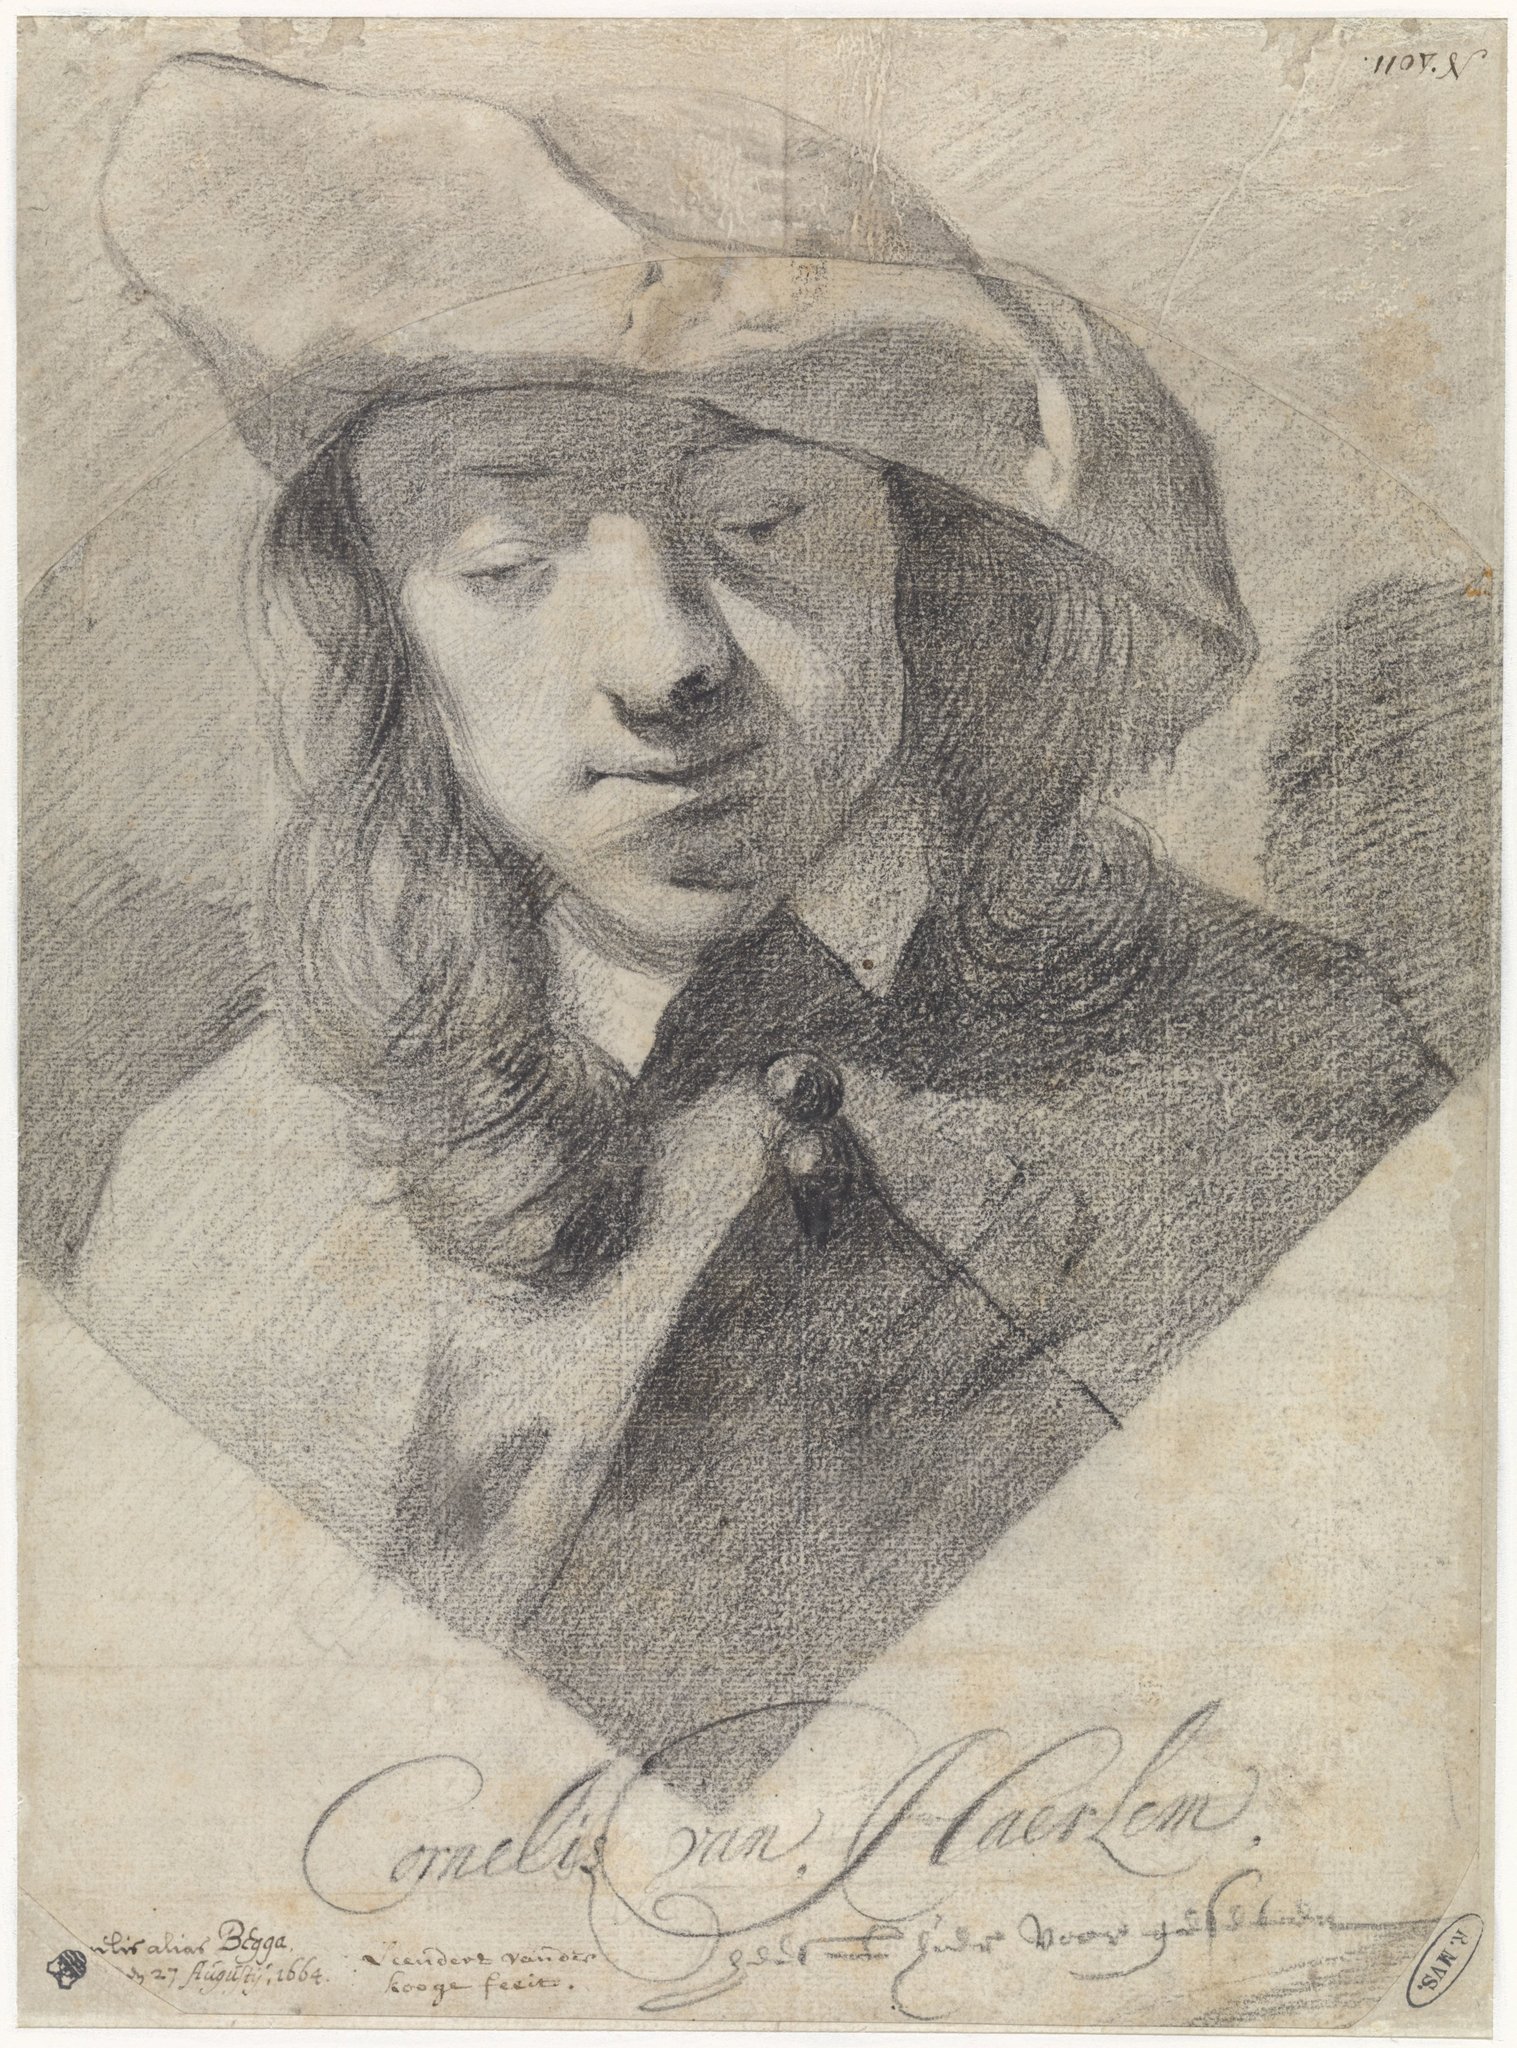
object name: drawing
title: Portret van Cornelis Bega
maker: leendert van der cooghen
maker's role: draughtsman, print maker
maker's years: 1632-1681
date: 1654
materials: chalk, paper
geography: haarlem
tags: cornelis cornelisz. van haarlem, historical persons, portrait, self-portrait of painter, portrait, self-portrait of artist, portrait, self-portrait of draughtsman